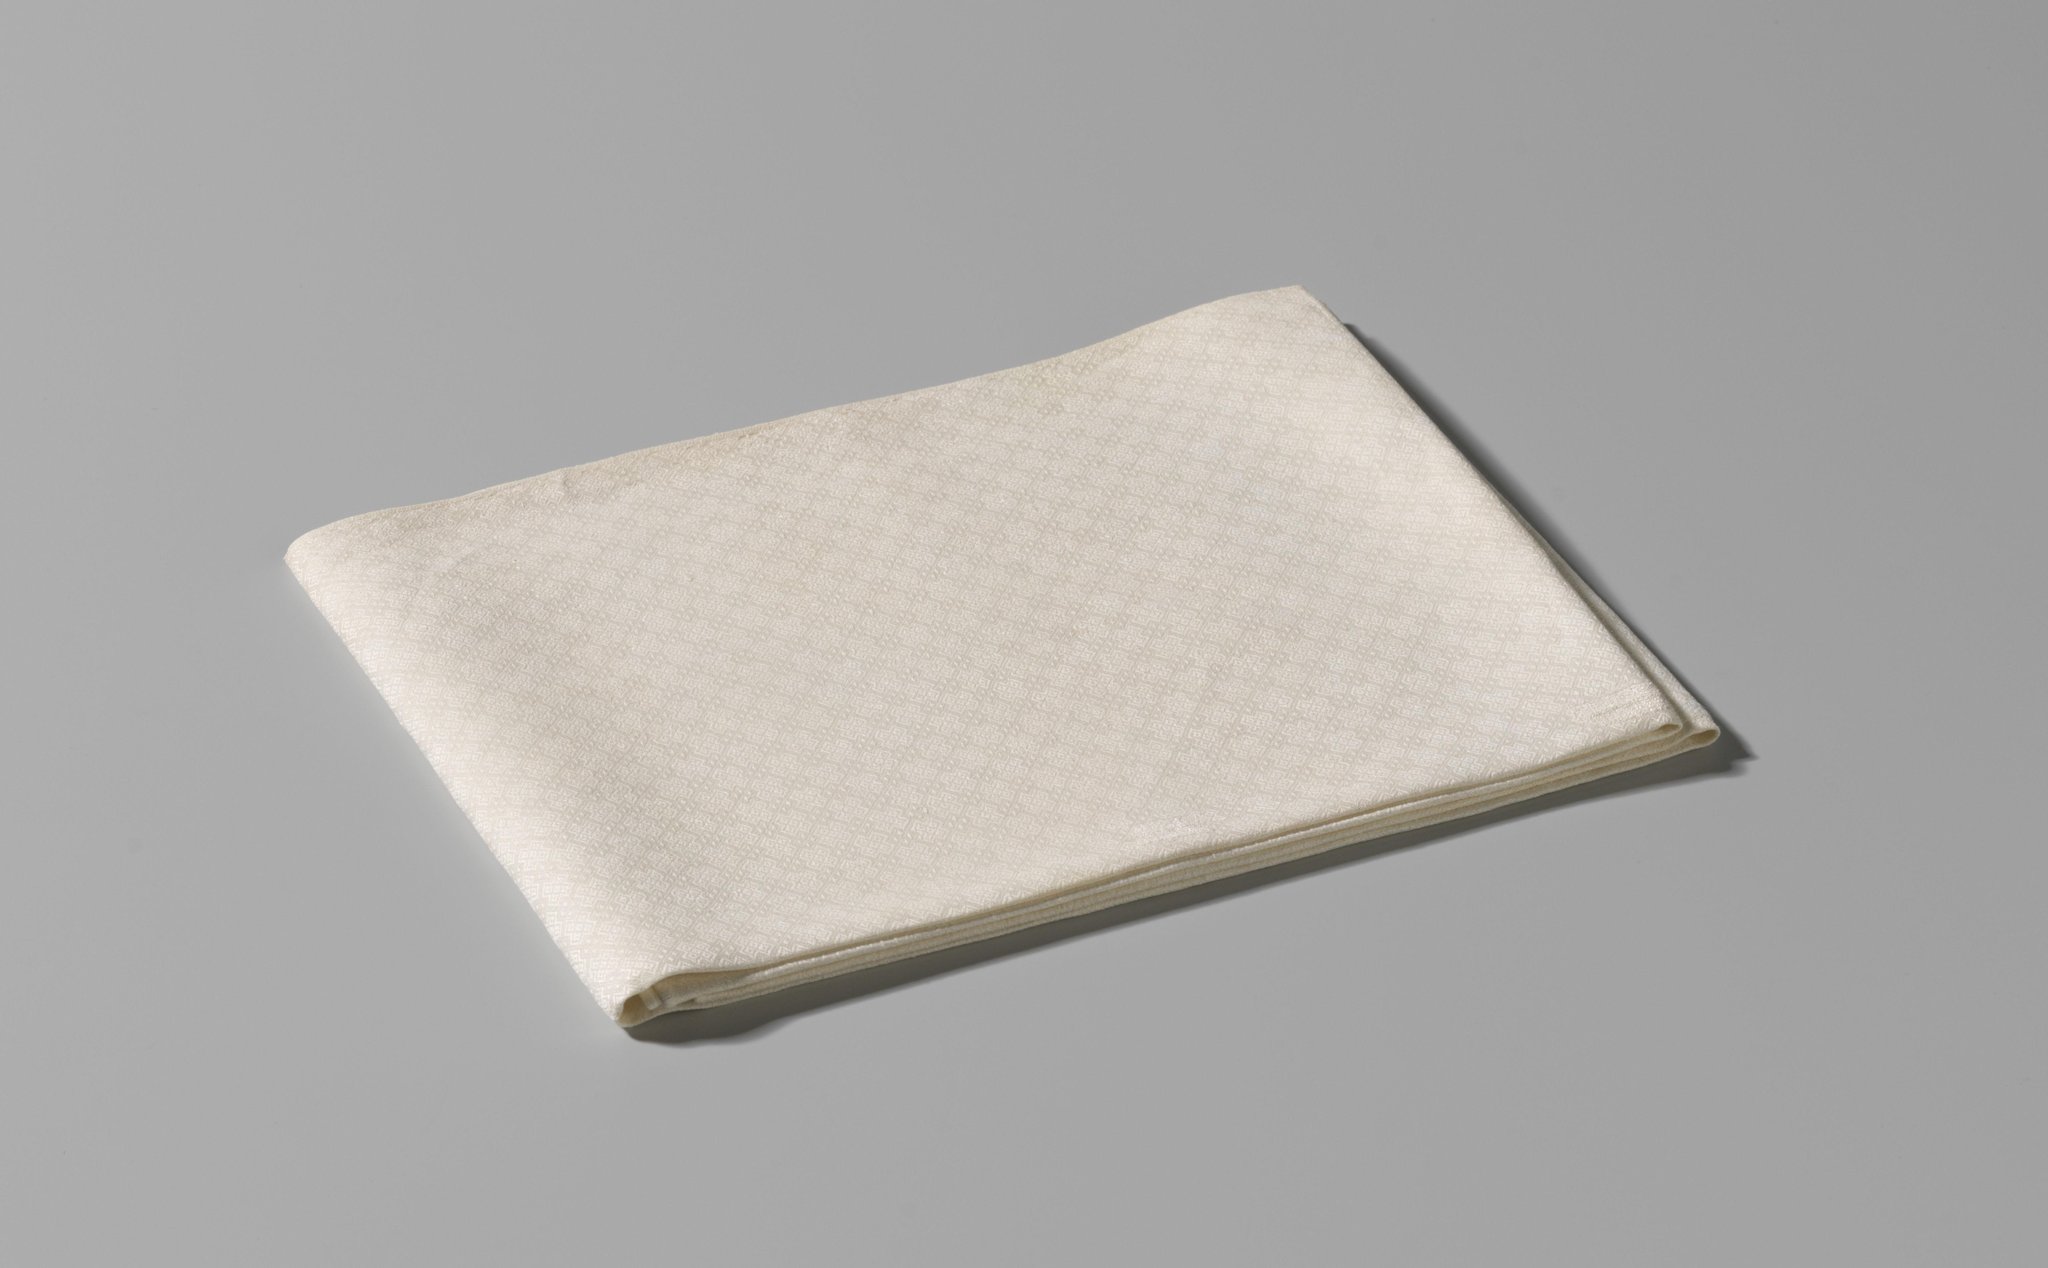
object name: woven material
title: Servet met kruiswerkpatroon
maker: Anonymous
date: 1600-1699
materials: linen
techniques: peeled fabric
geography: northern netherlands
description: Servet van linnendamast met kruiswerkpatroon. Oneindig rapport van kleine enkelvoudige overhoekse kruizen waarin vijf punten, omsloten door elkaar kruisende diagonalen op de kruispunten, waarvan ruiten met vier stippen.